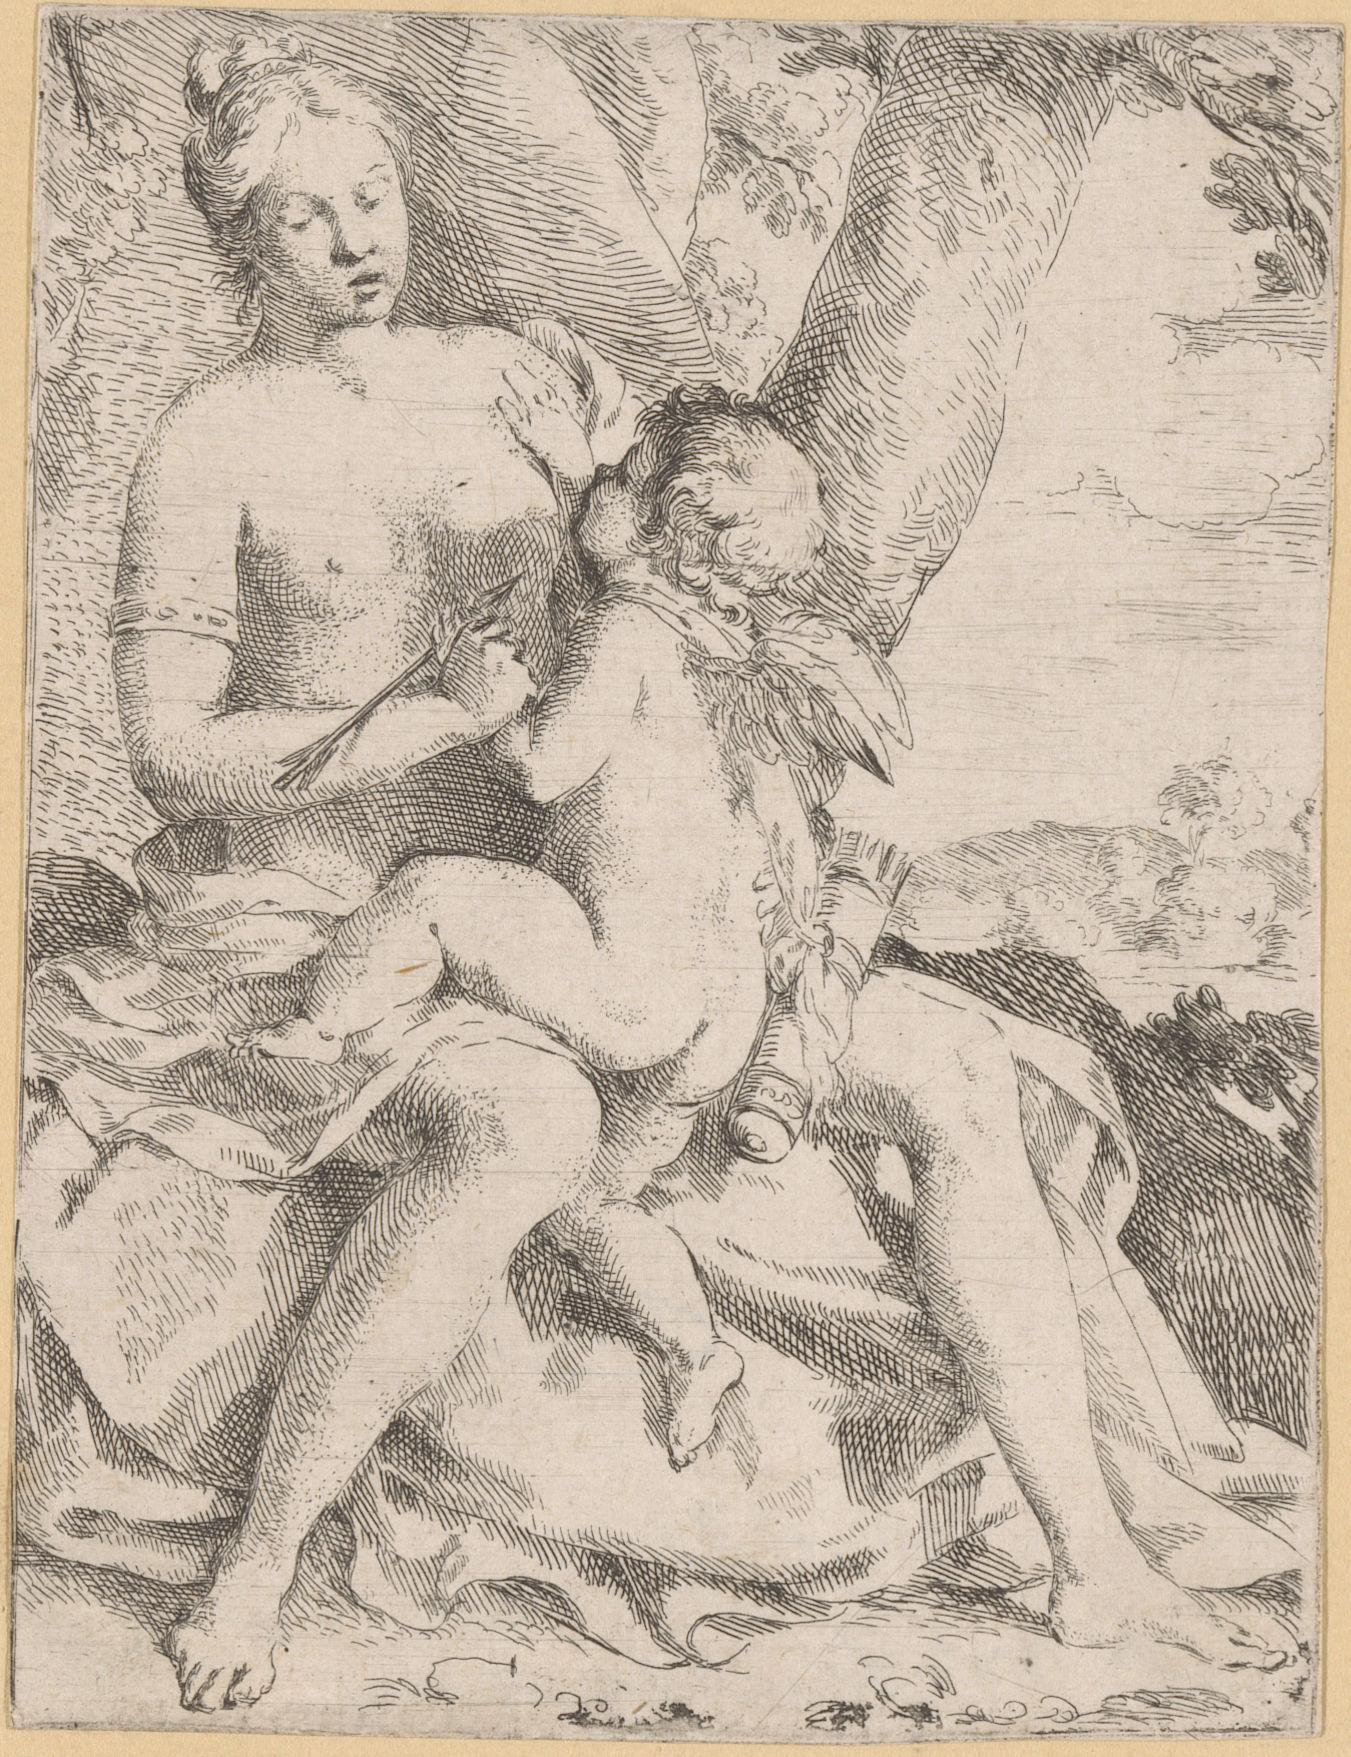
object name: print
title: Venus en Amor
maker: Anonymous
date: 1550-1650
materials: paper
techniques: etching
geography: italy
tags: venus and cupid (cupid not being mere attribute)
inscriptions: collector's mark: Lugt 240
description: Venus zit met Amor op haar schoot. Ze pakt Amor bij zijn linkerarm.